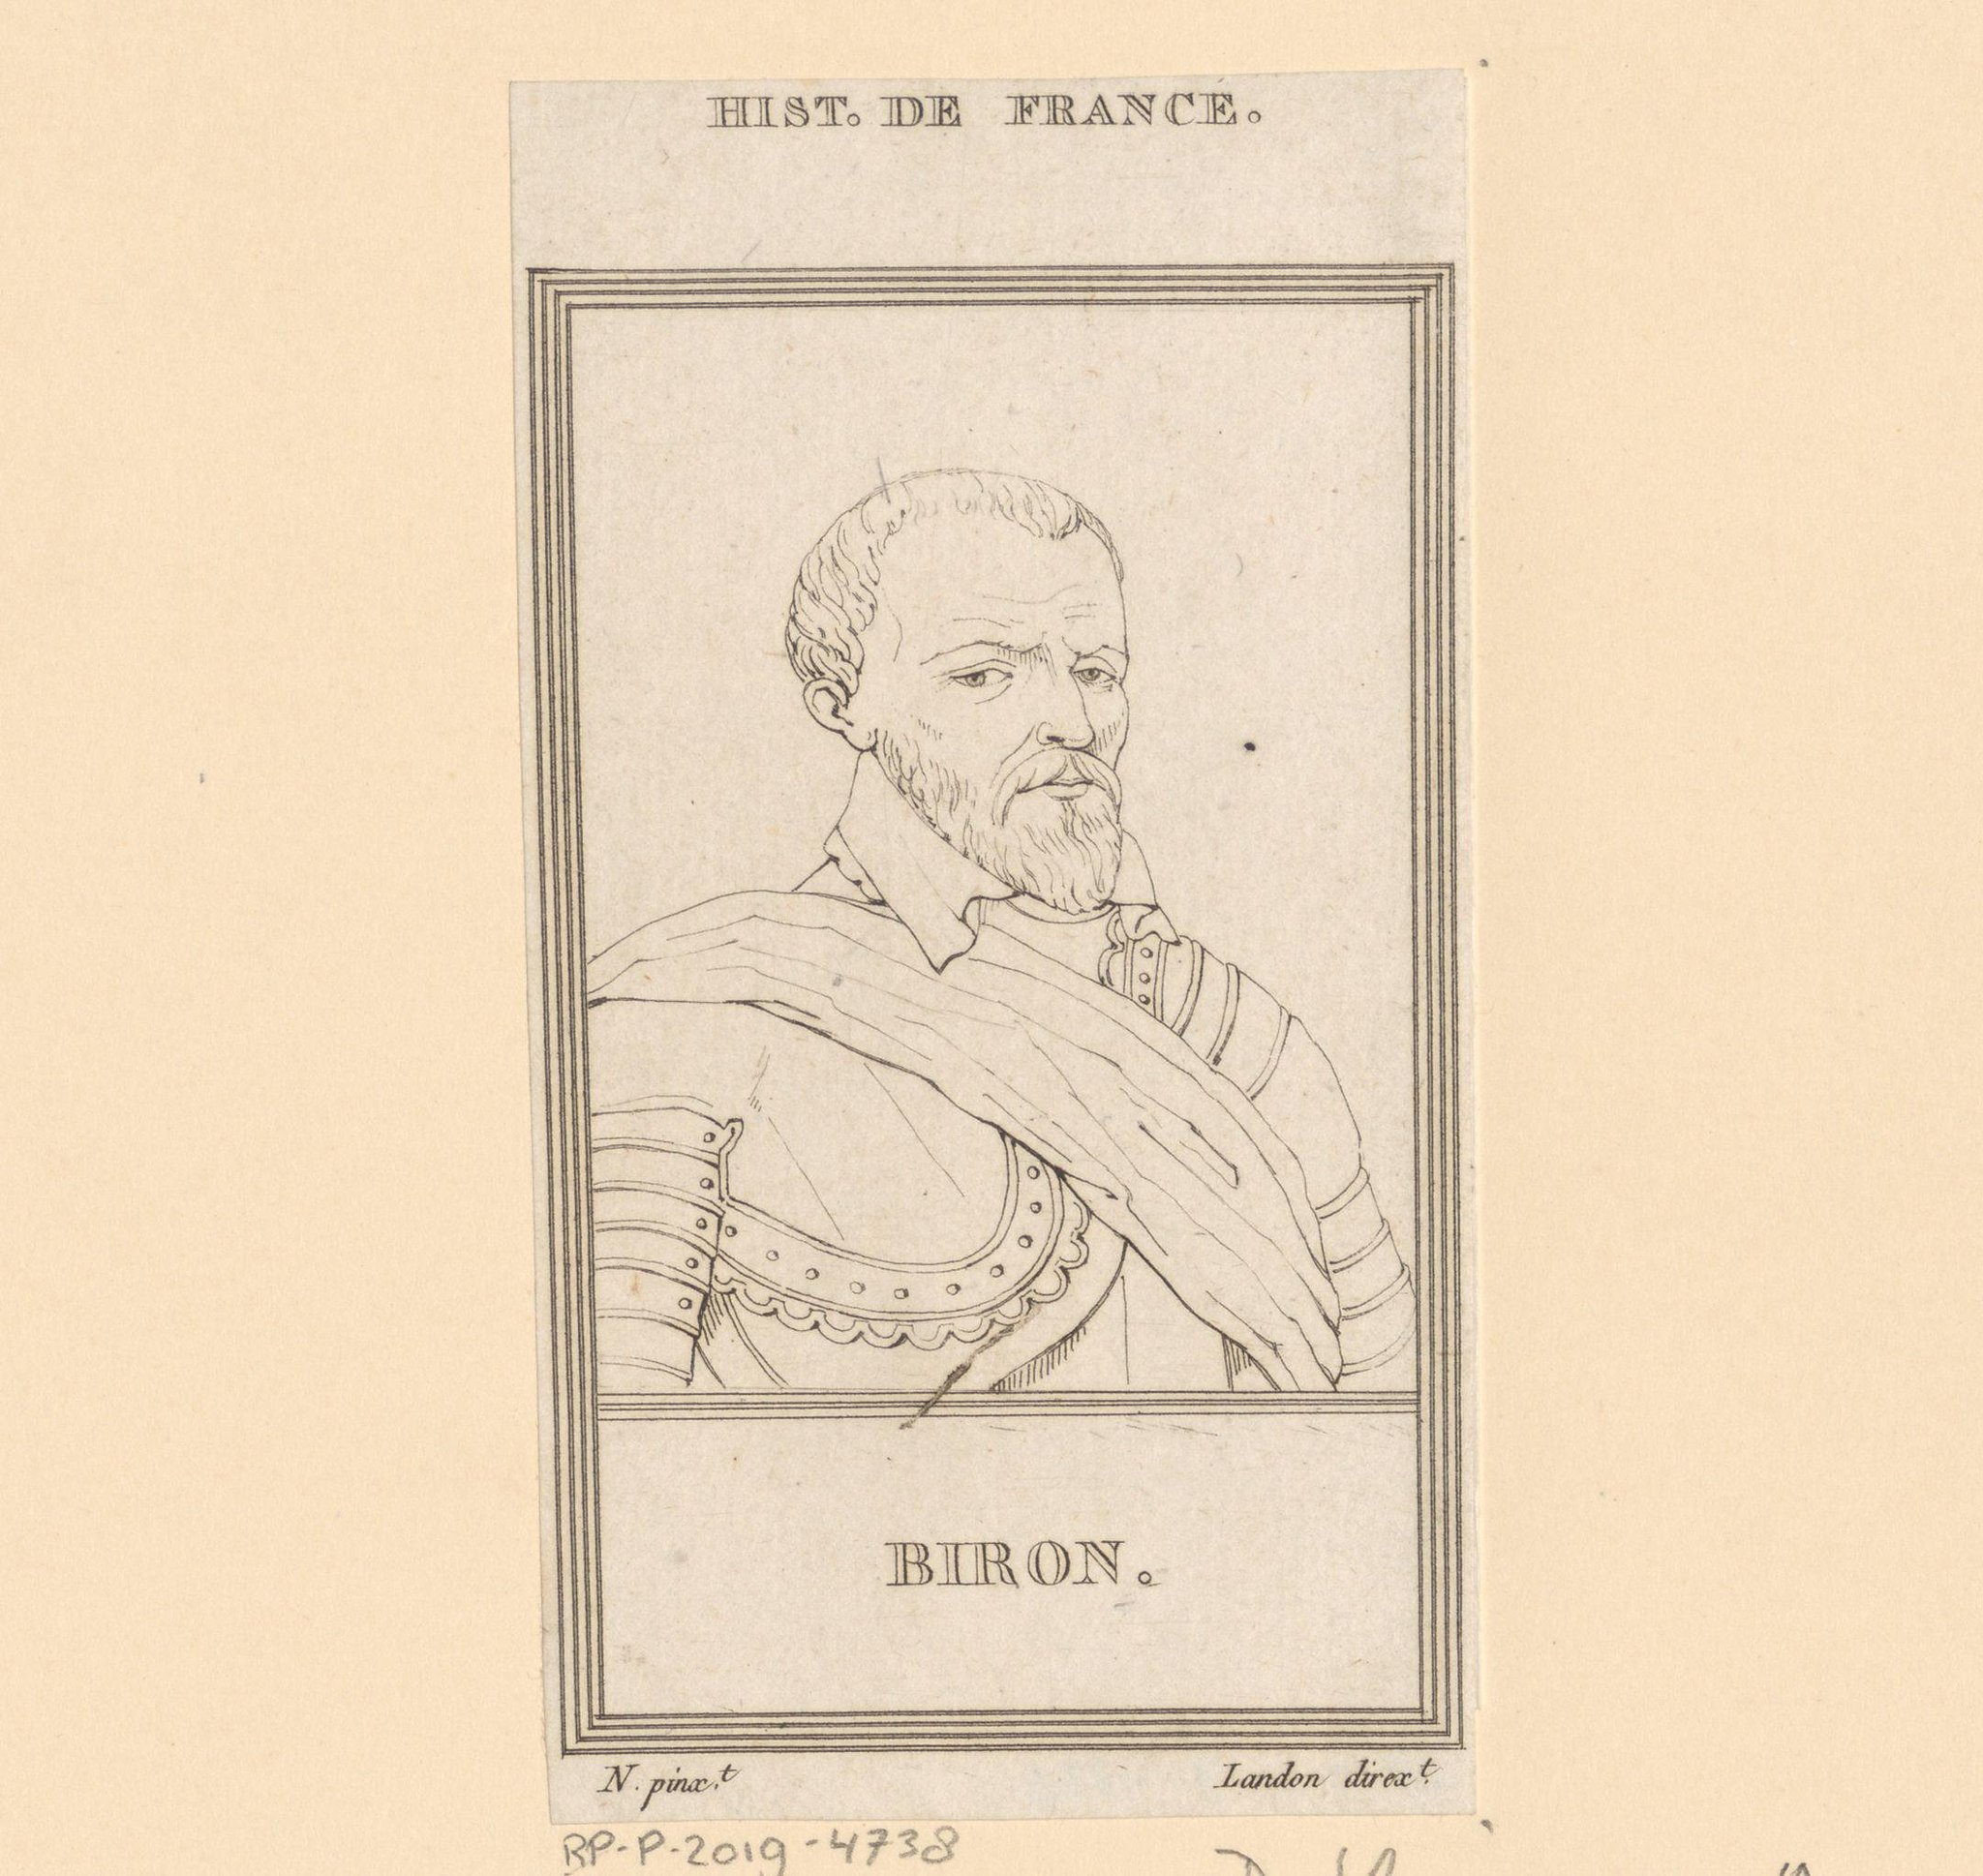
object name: print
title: Portret van Armand de Gontaut, heer van Biron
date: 1805-1811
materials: paper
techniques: etching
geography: paris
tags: armour, historical persons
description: Prent uit: Galerie historique des hommes les plus célèbres (...). Parijs: Charles Paul Landon, 1805-1811.